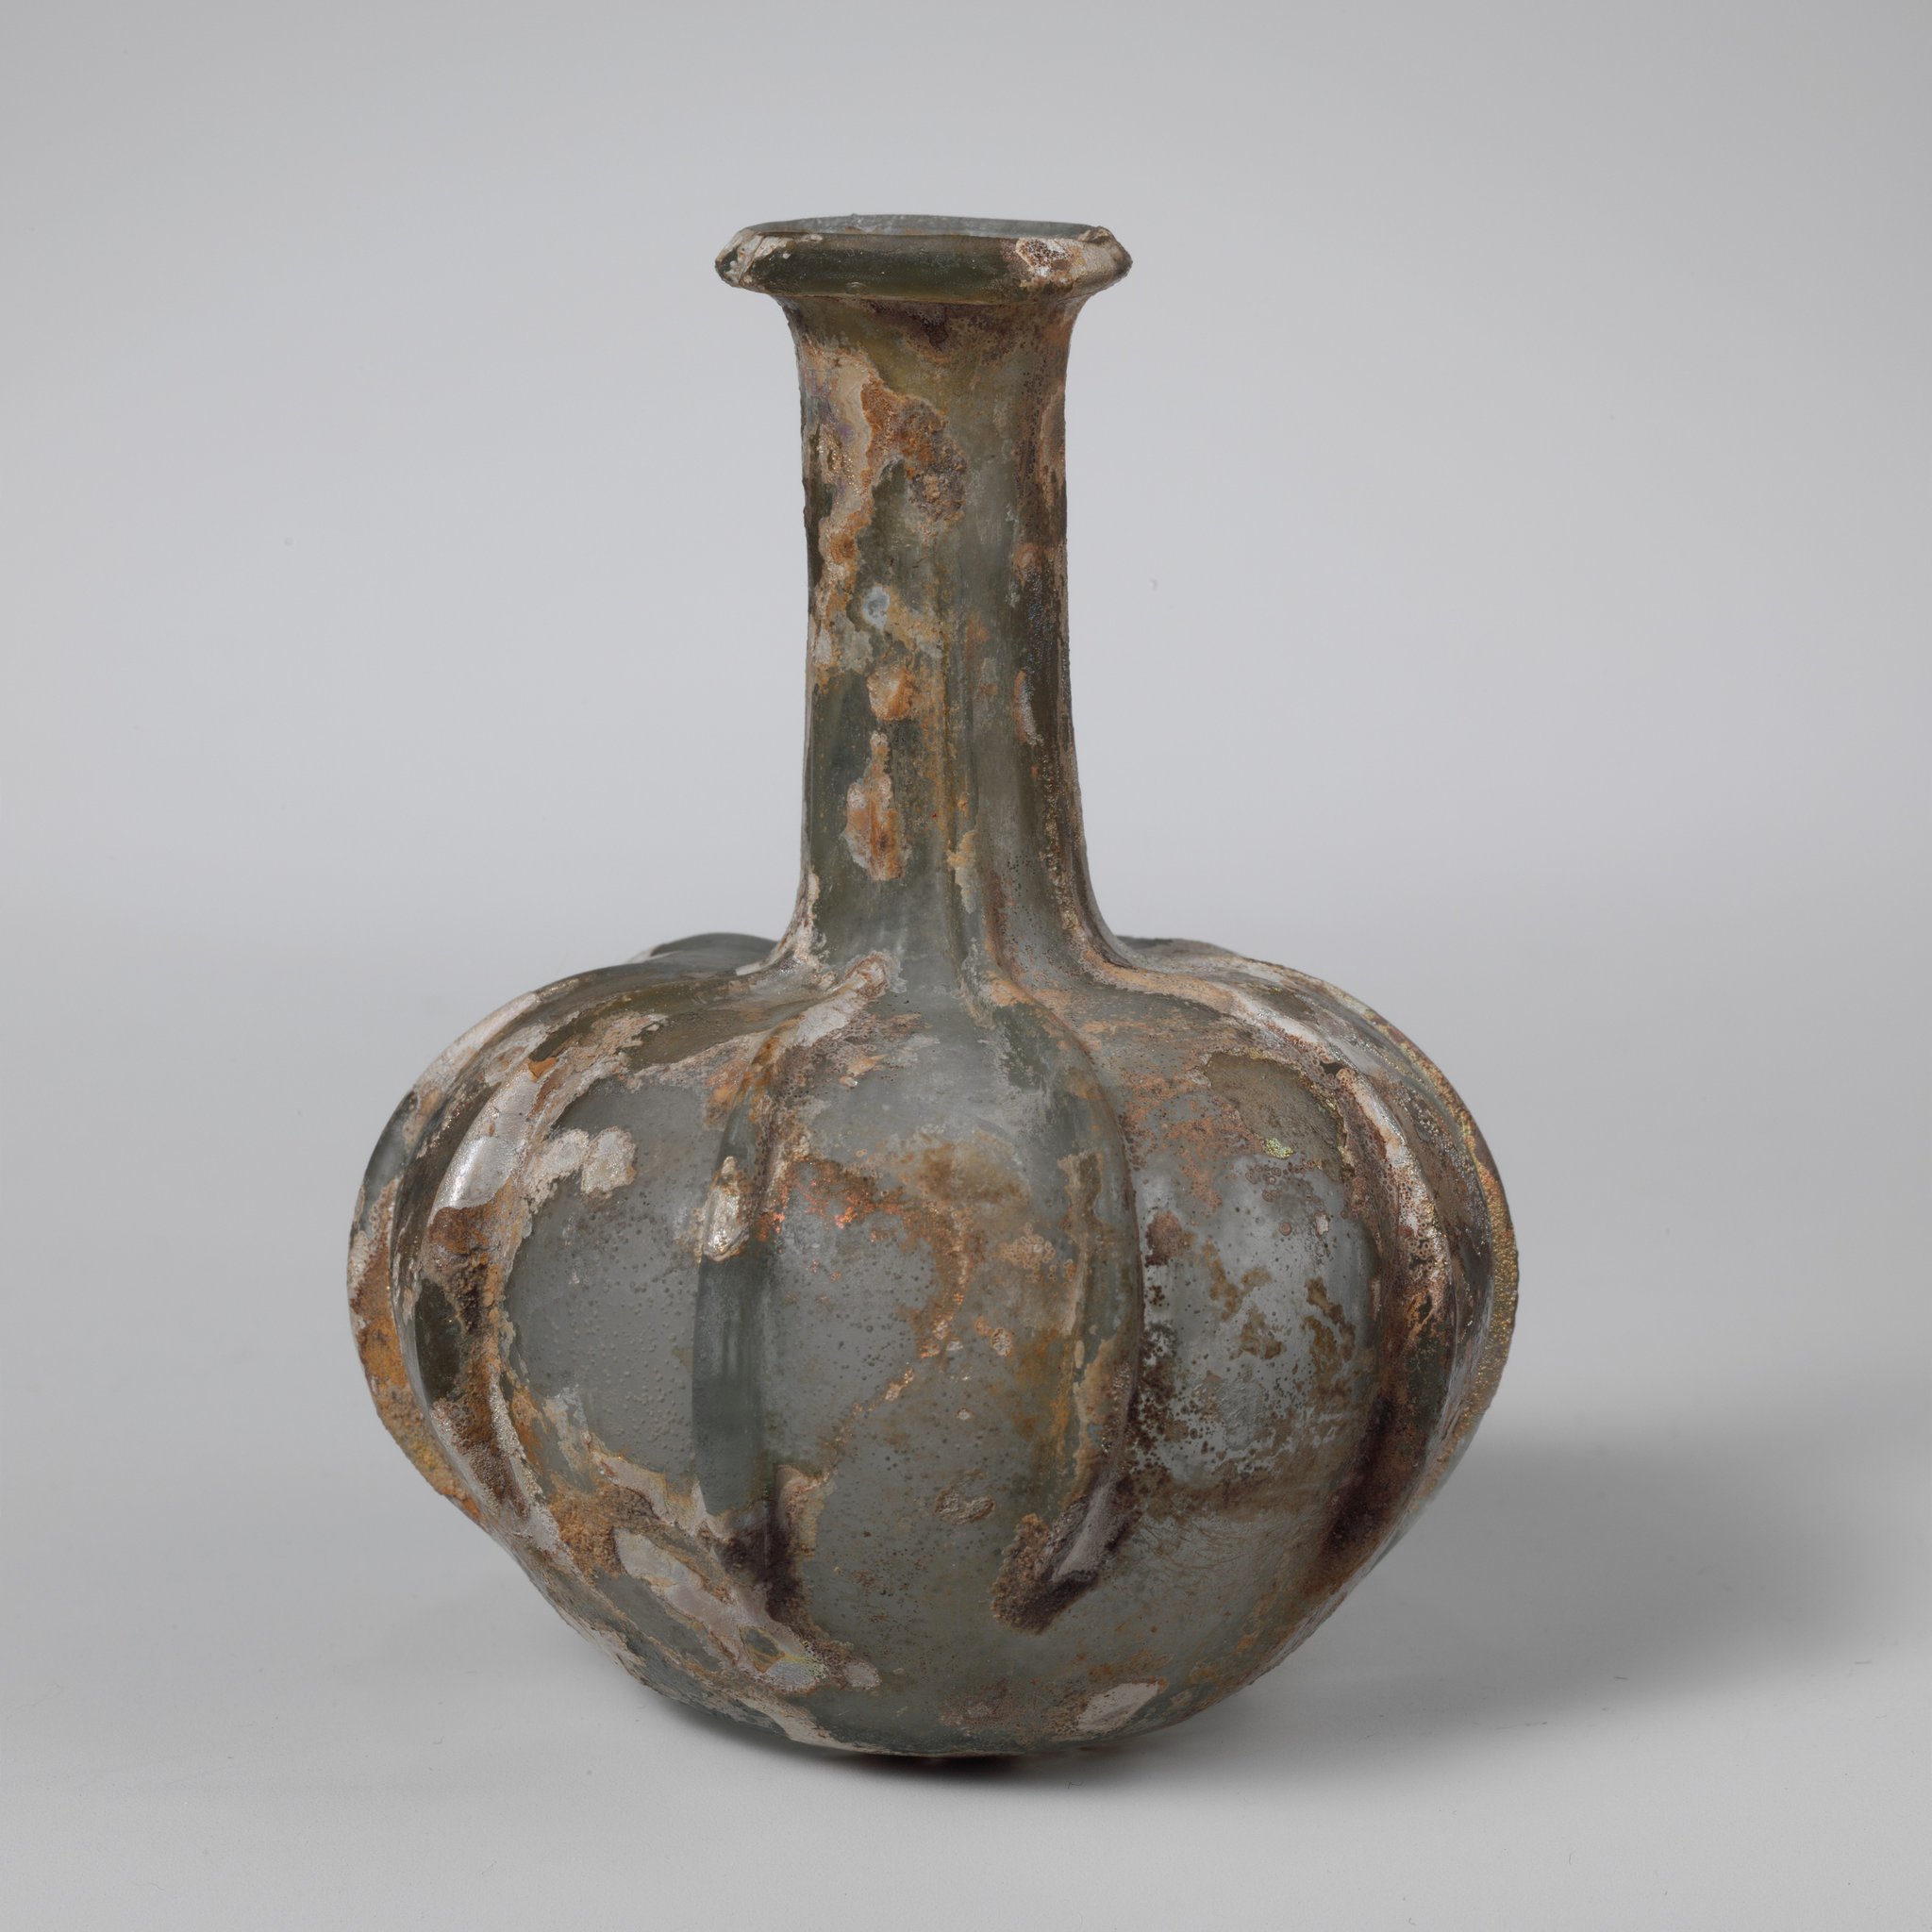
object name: bottle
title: Glass bottle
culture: roman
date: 101-200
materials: glass